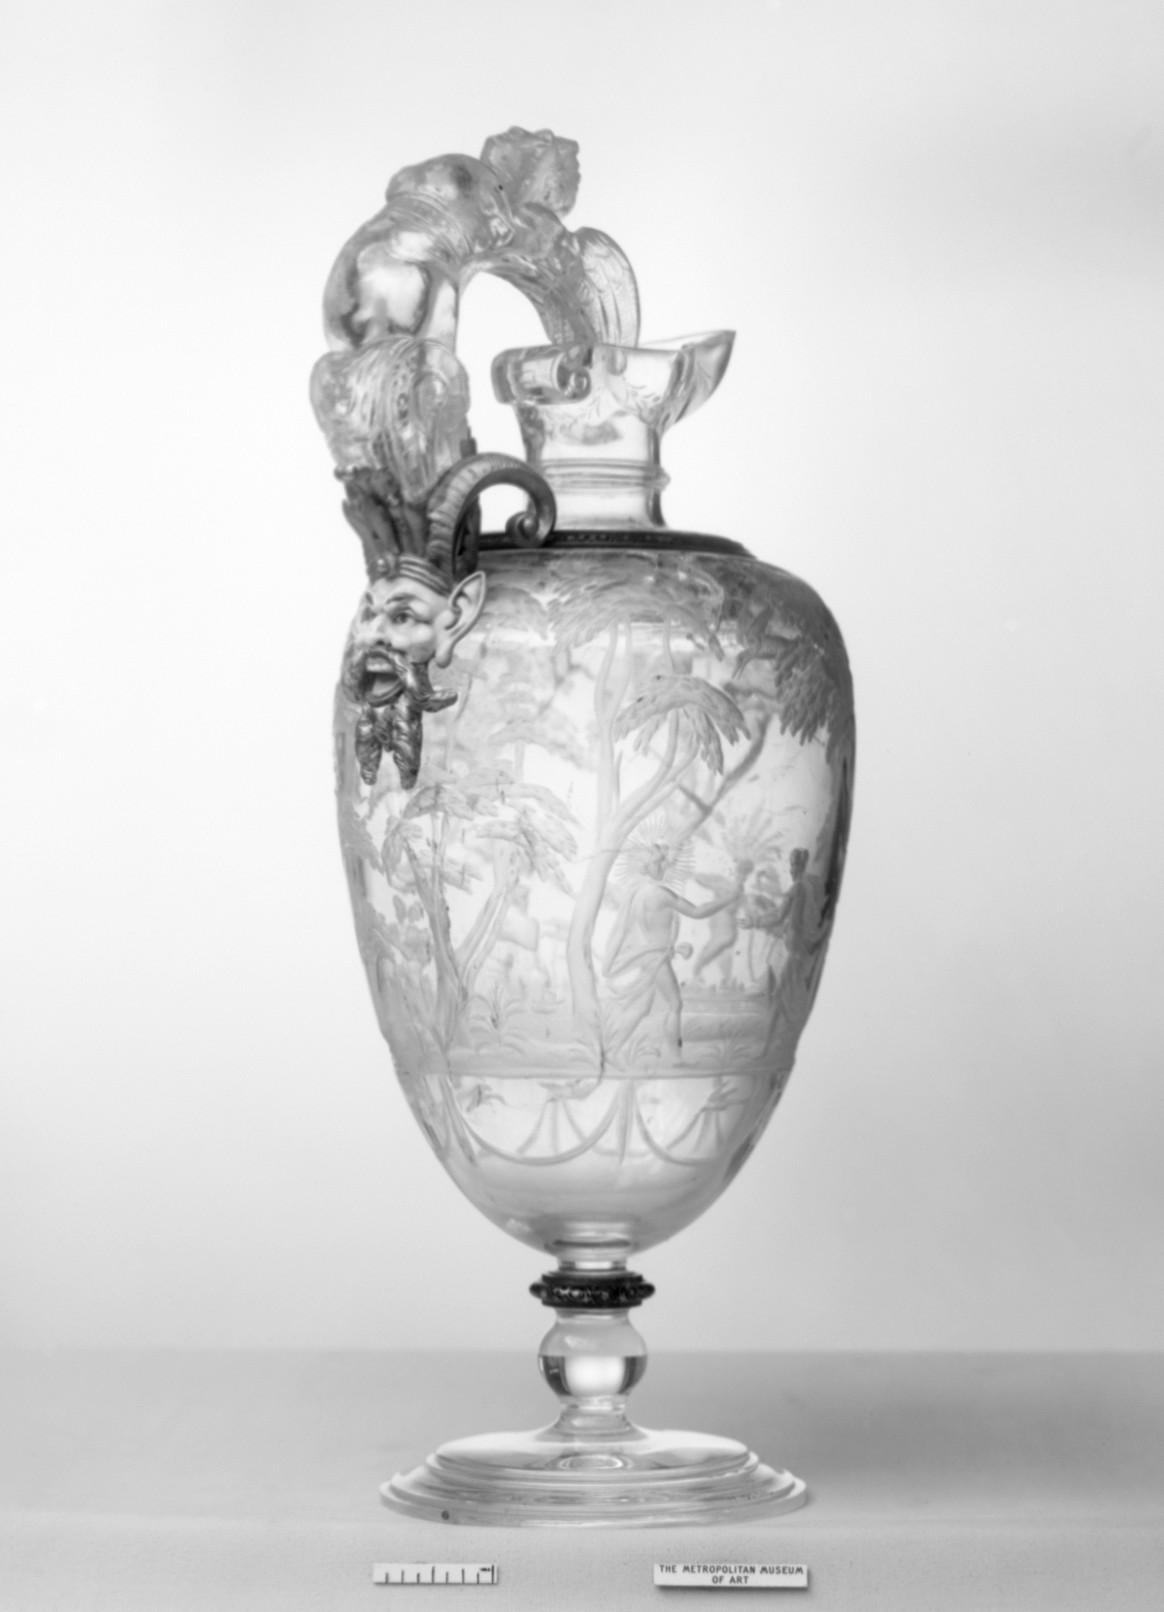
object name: ewer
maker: charles duron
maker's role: maker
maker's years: 1814-1872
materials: enamel, gold, quartz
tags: human figures,masks,trees